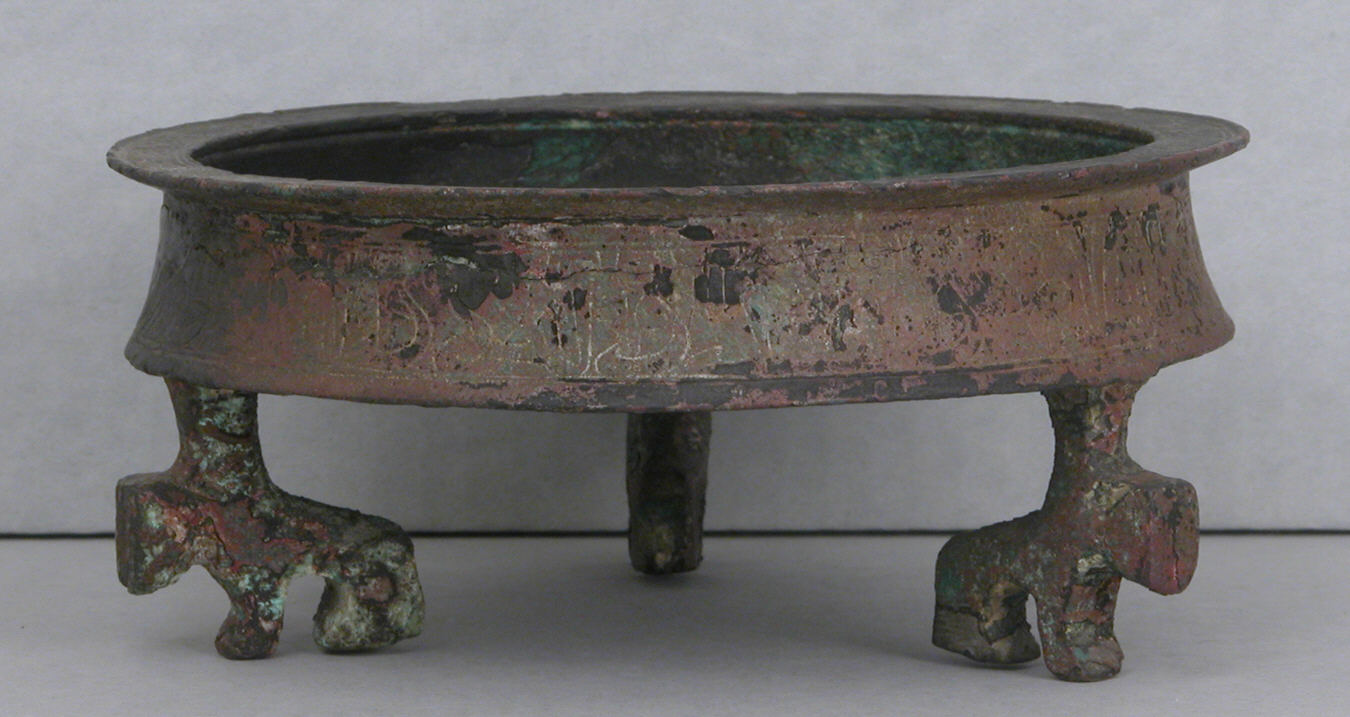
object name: incense burner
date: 1167-1200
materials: alloy, bronze, silver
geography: iran